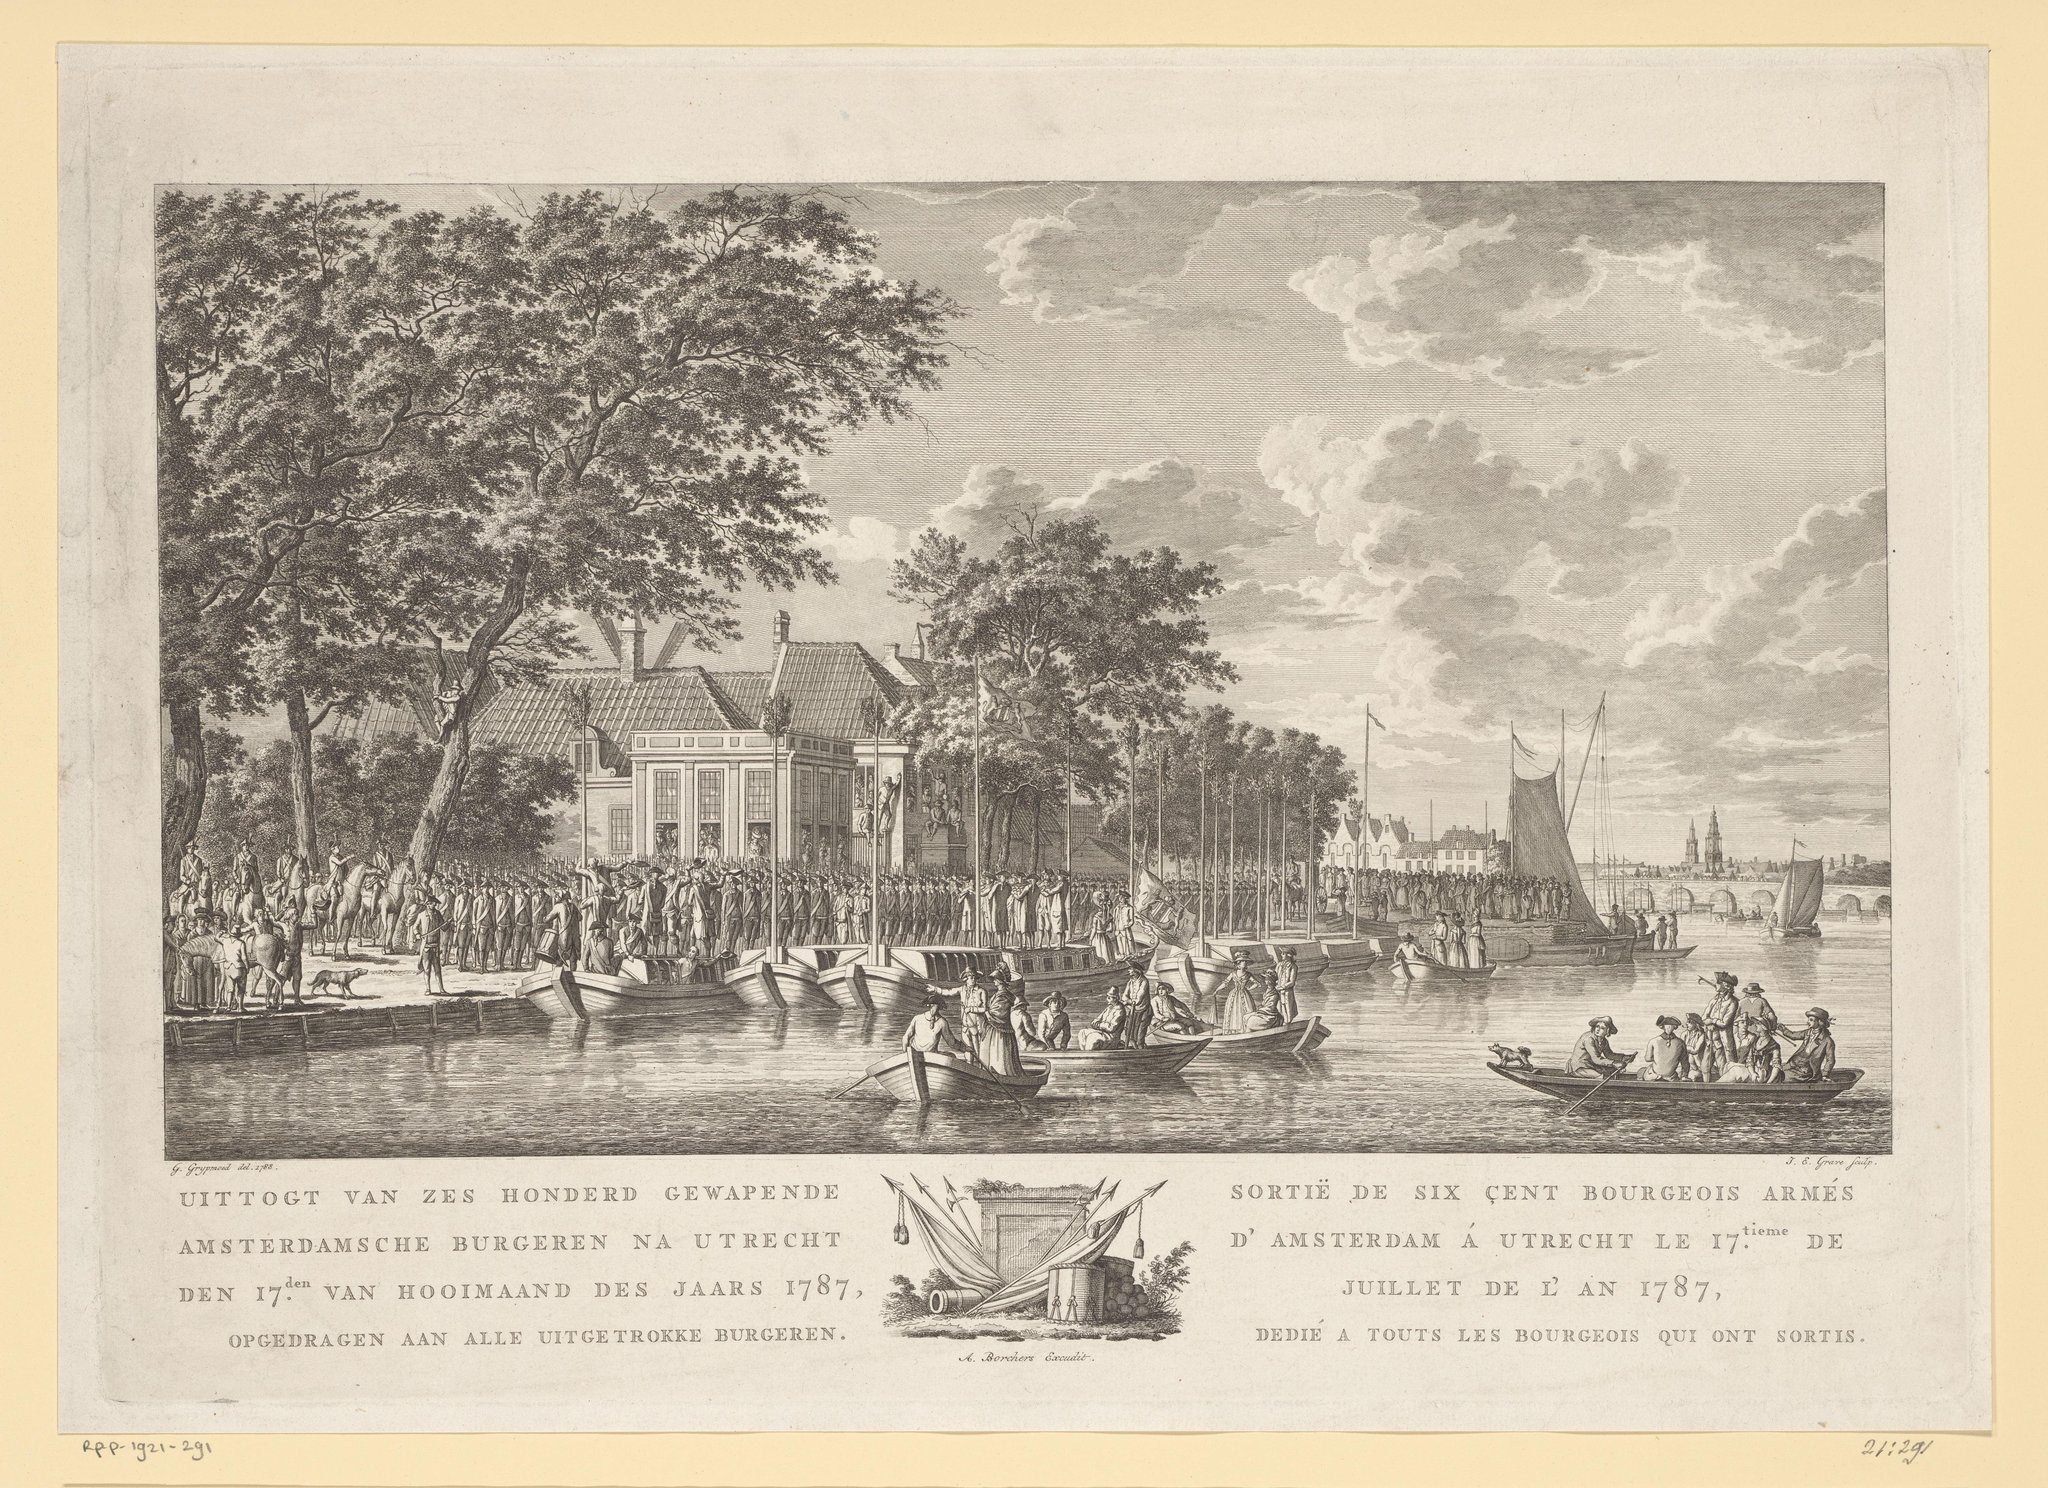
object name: print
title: Uittogt van zes honderd gewapende Amsterdamsche burgeren na Utrecht den 17den van hooimaand des jaars 1787 / Sortië de six cent (...)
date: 1788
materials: paper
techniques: engraving, etching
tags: patriotism, warfare; military affairs, patriots (1780-1795)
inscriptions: date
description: Onder het toeziend oog van het toegestroomd publiek bij herberg de Berebijt vertrekken zeshonderd Amsterdamse burgers op 17 juli 1787 uit Amsterdam naar Utrecht, om daar het patriottenleger aan te vullen. De prent heeft een Nederlands en Frans onderschrift.